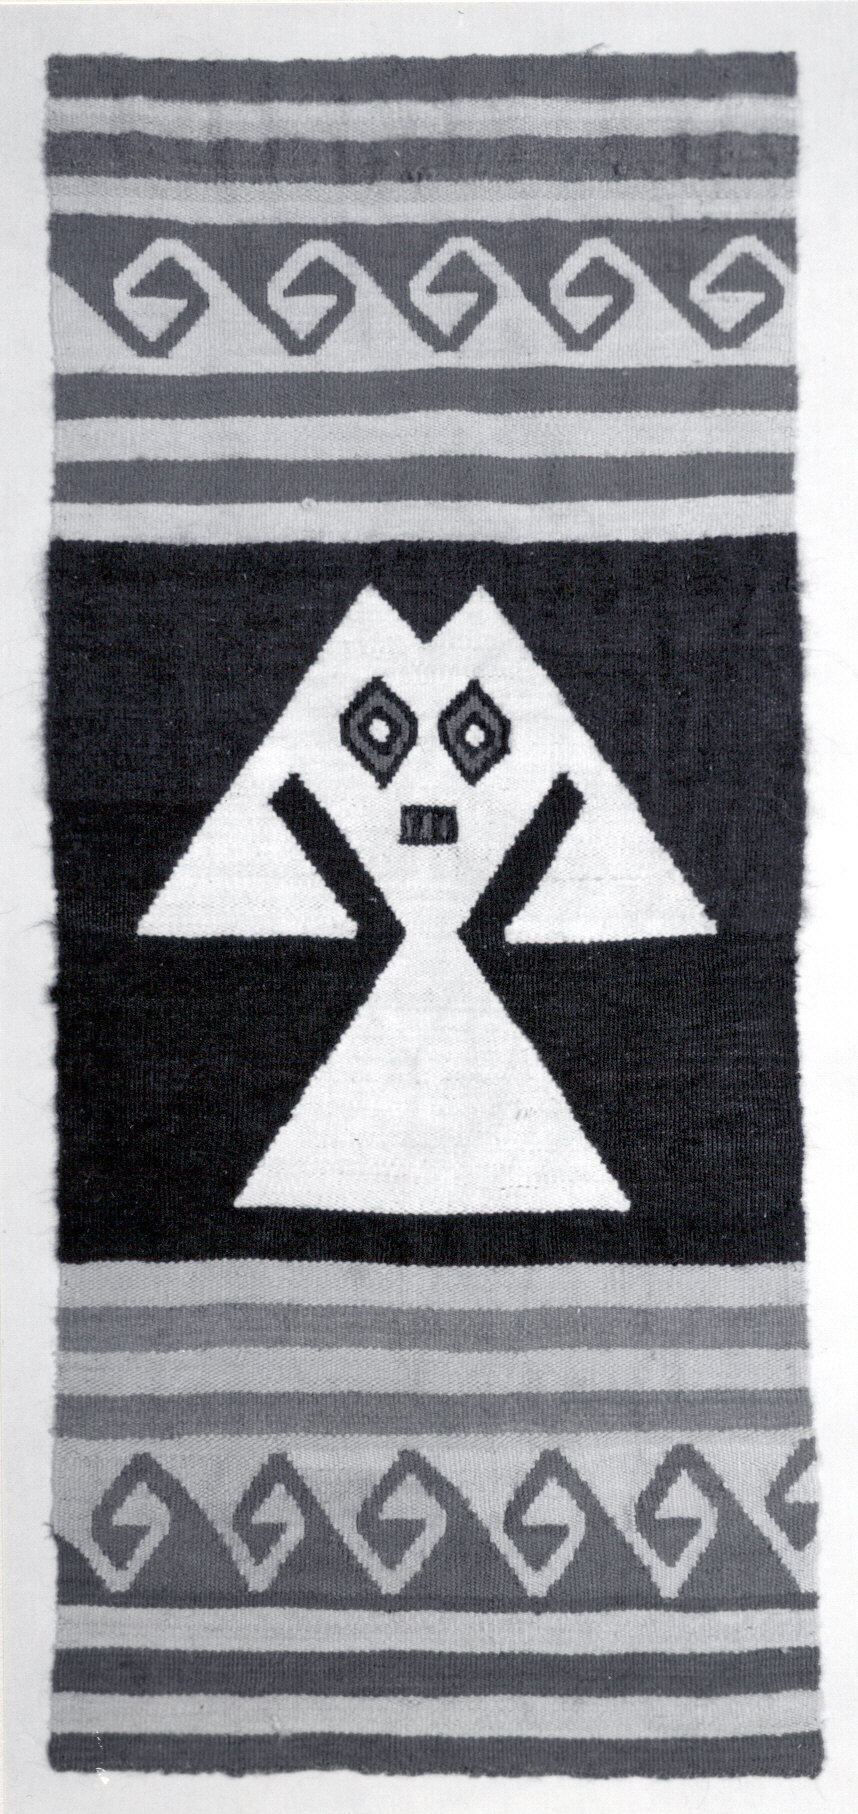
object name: loincloth fragment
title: Loincloth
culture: chancay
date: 1101-1400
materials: animal fiber, cotton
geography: peru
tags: animals